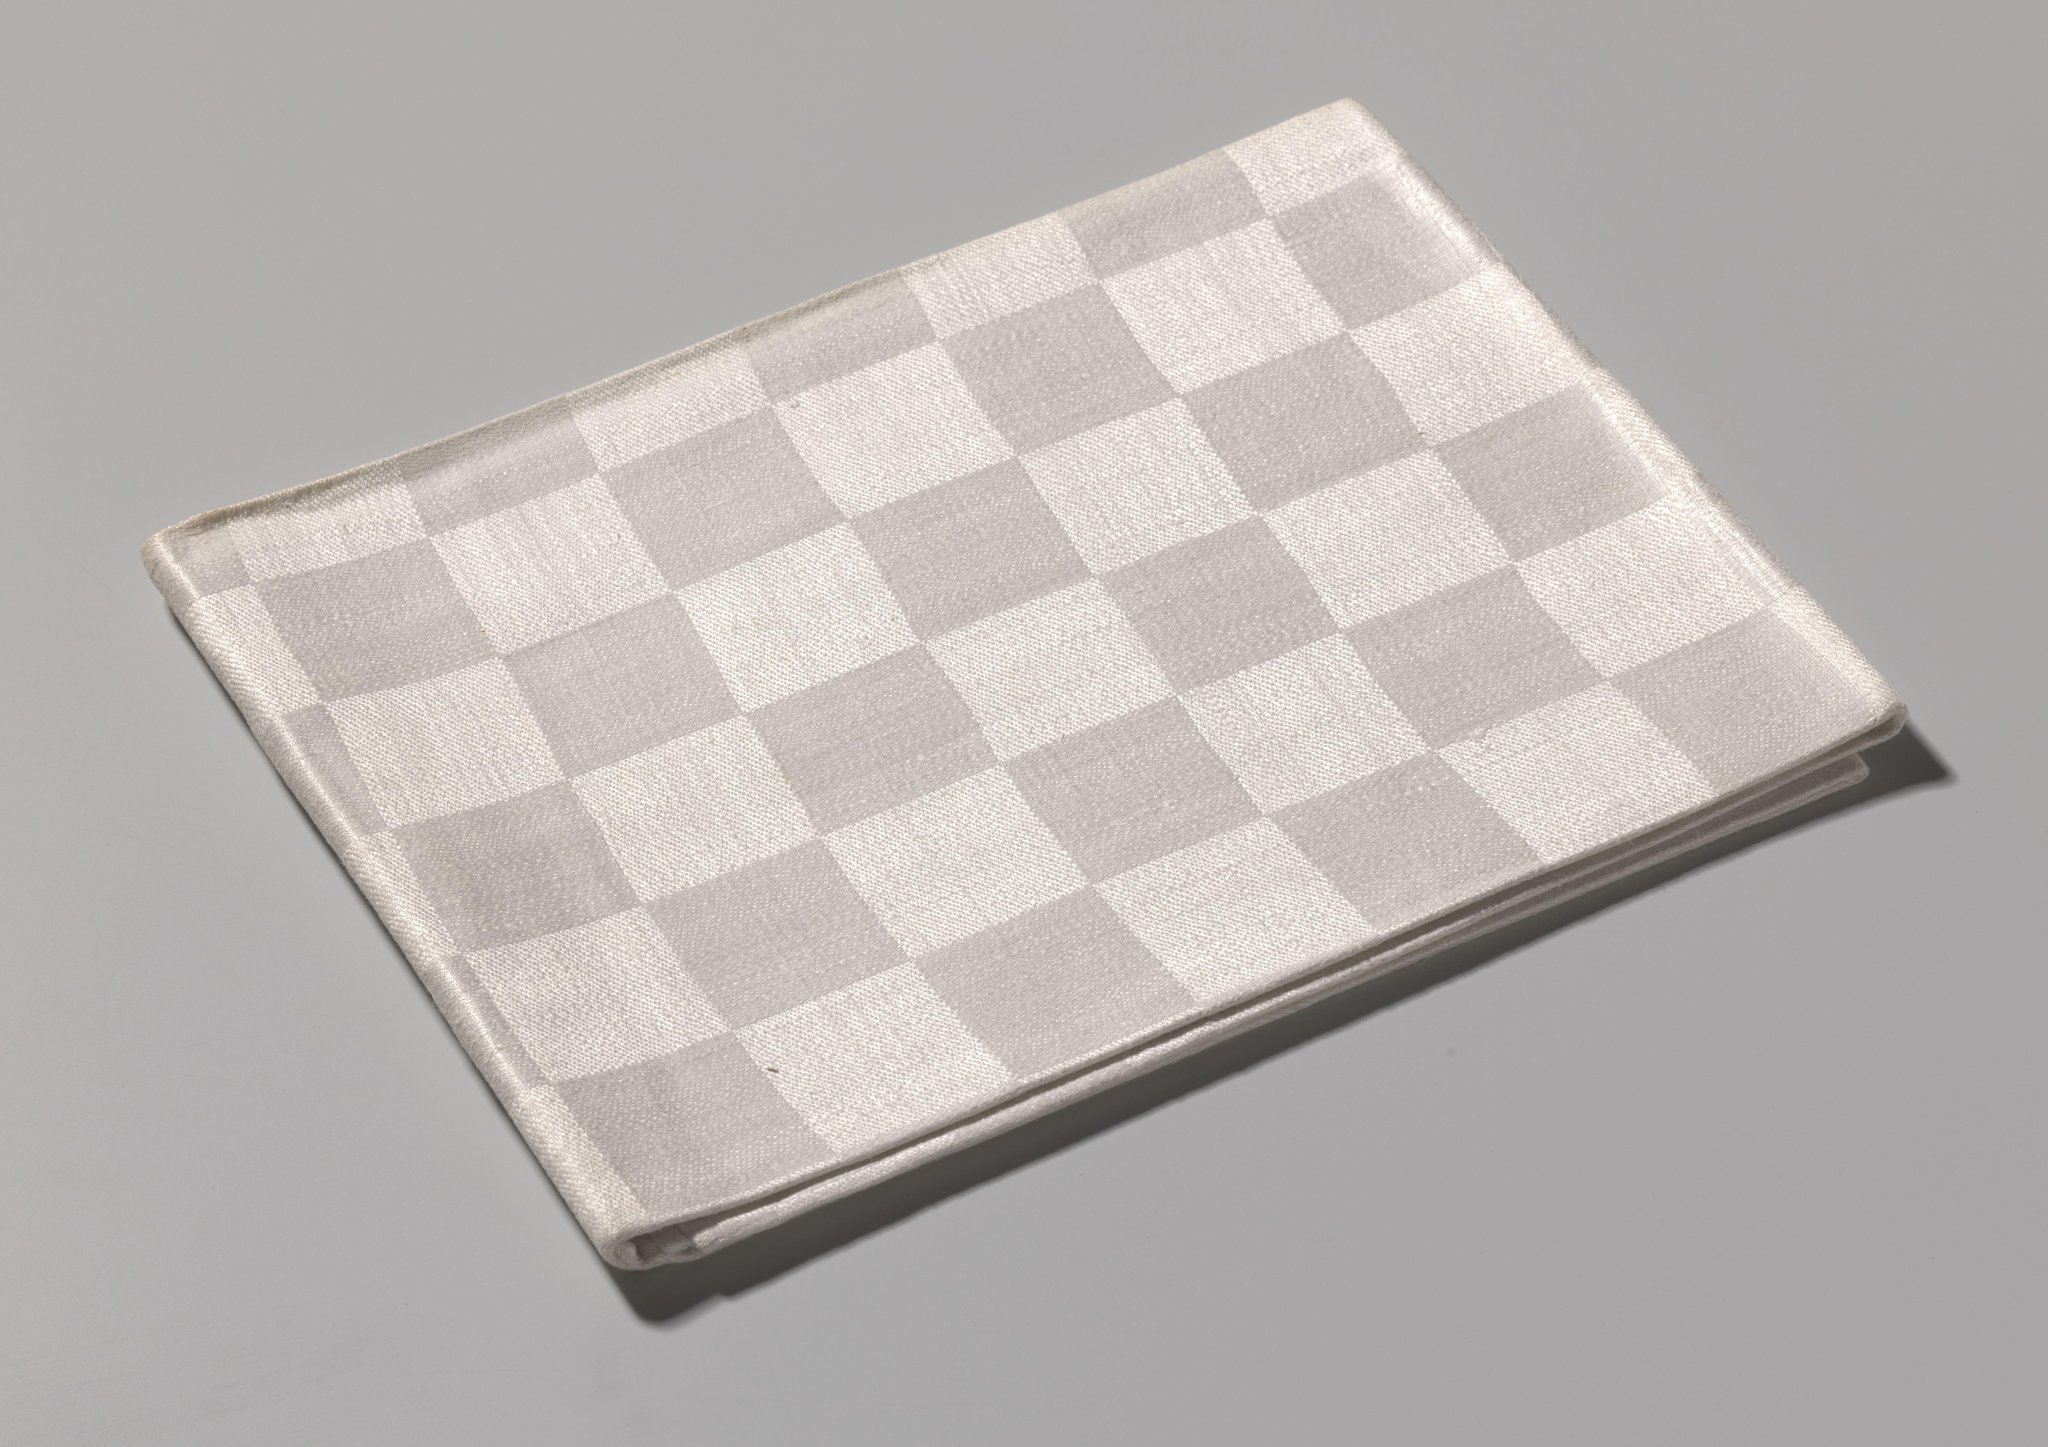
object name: napkin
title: Servet van linnen met pellenpatroon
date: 1830-1870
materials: linen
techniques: peeled fabric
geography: northern netherlands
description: Wit linnen servet met pellenpatroon, merk HW 80.